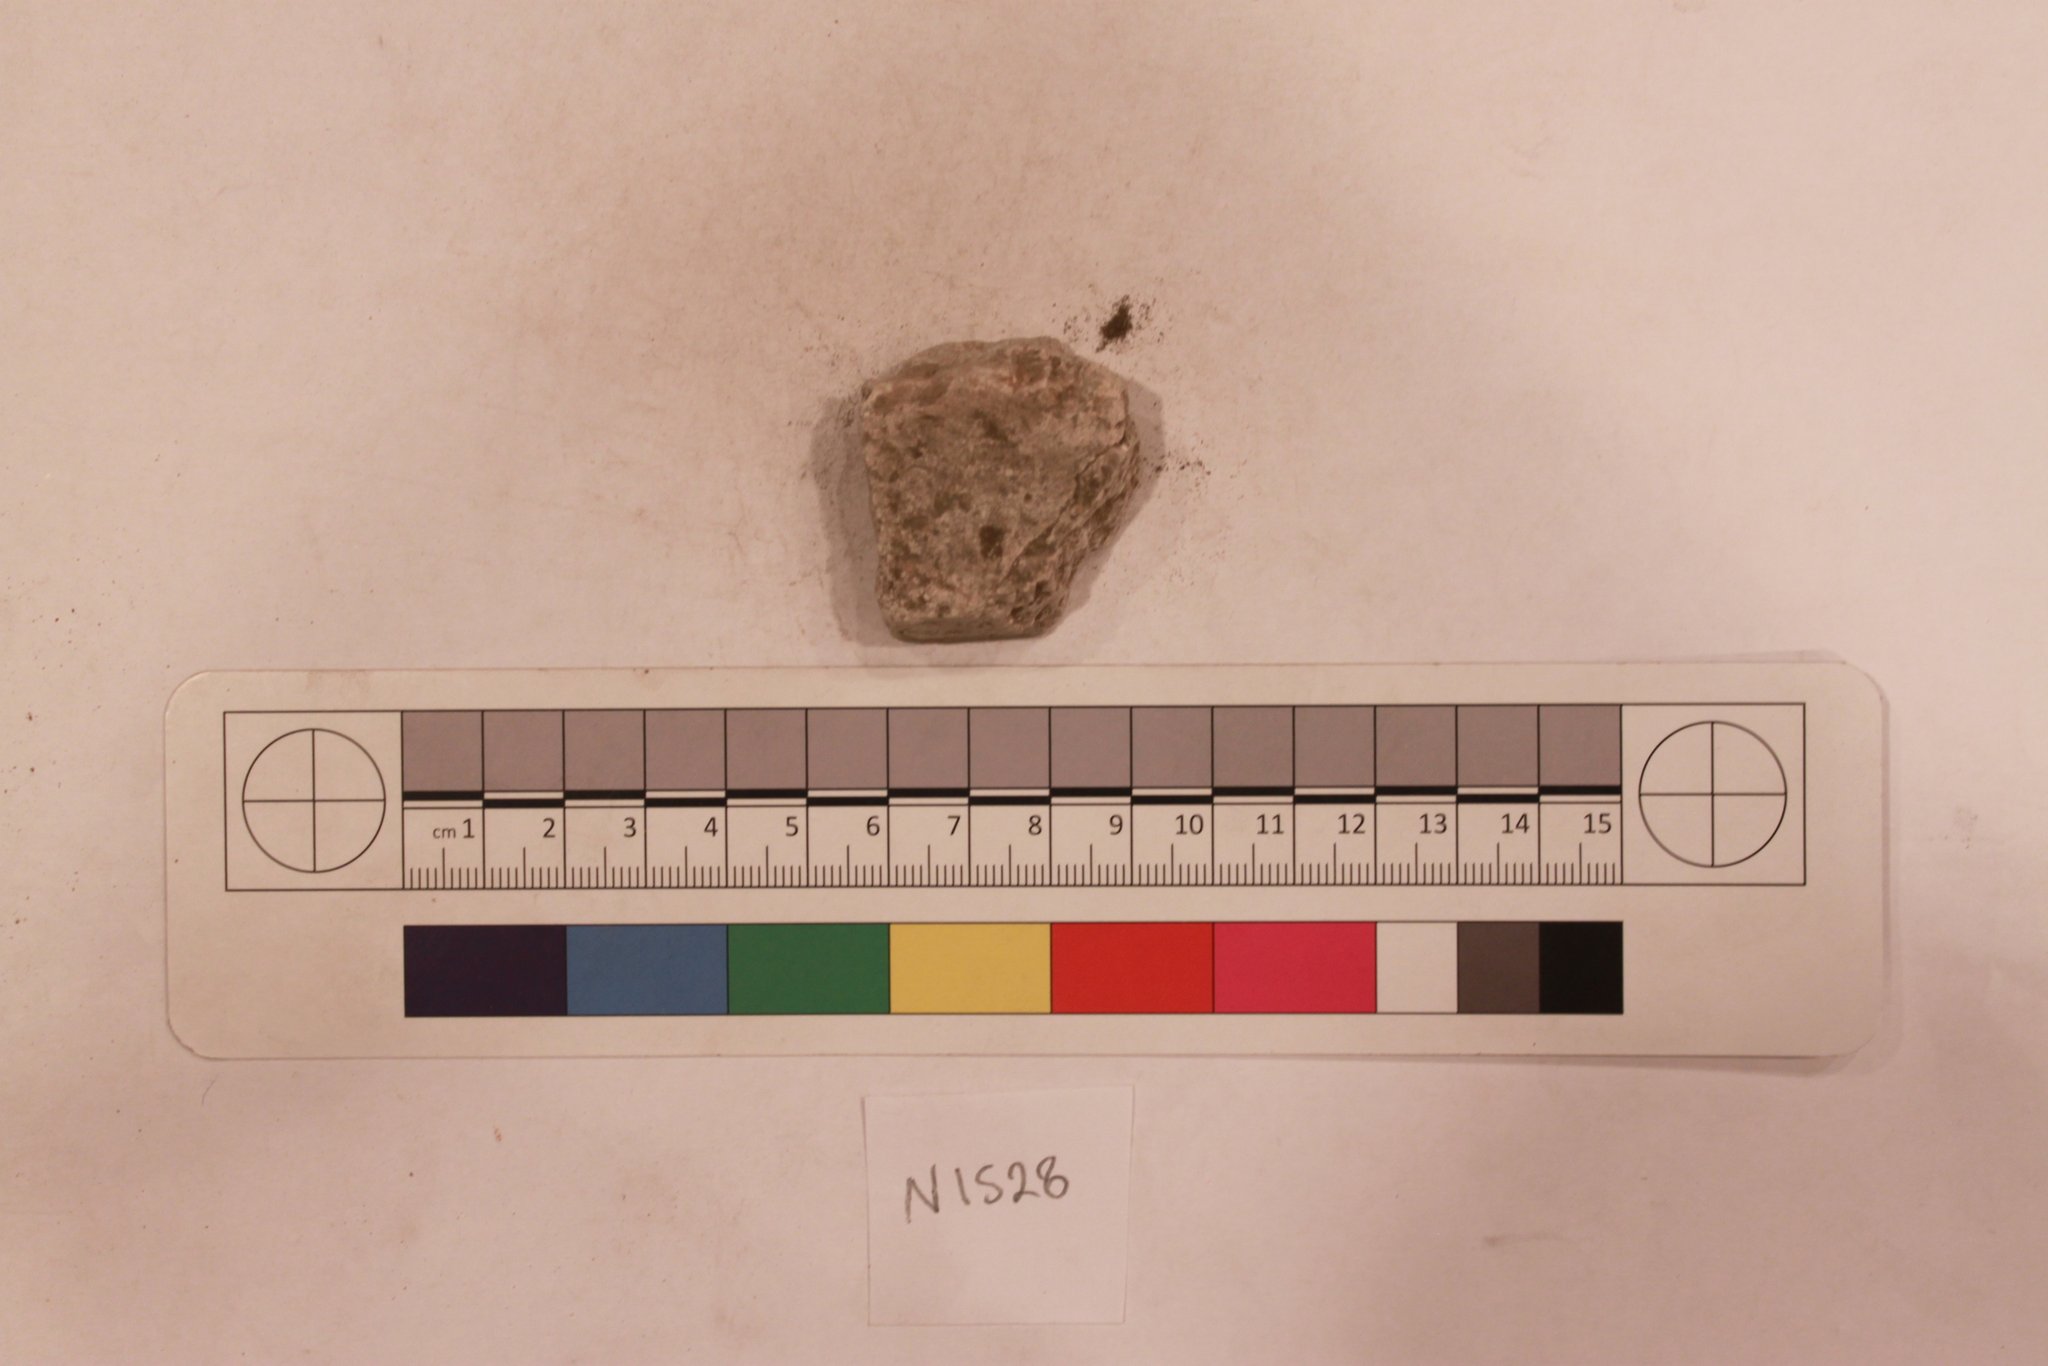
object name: fragment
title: Stucco Fragment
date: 701-1200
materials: plaster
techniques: carving, painting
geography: iran